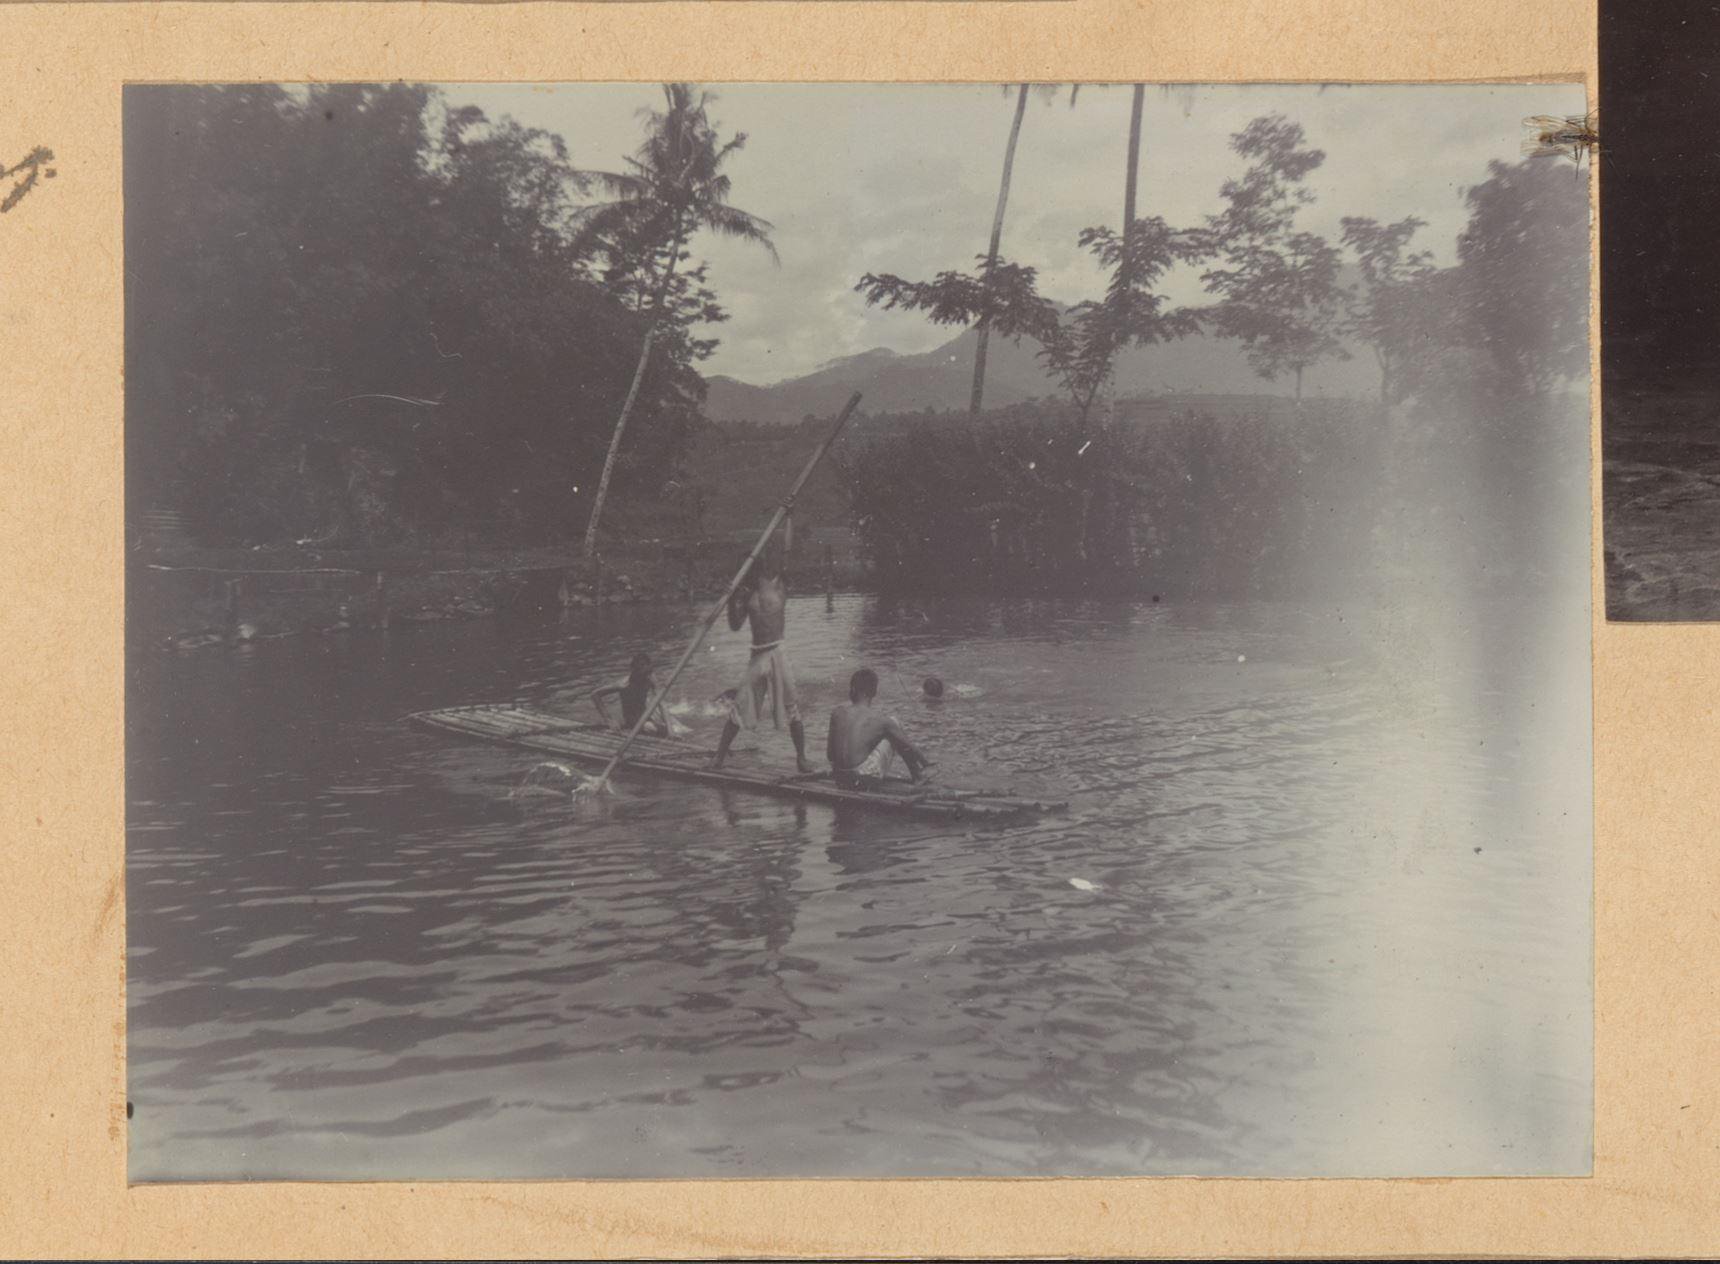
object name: photograph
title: Jongens op een vlot bij Kali Taman in Nederlands-Indië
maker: Anonymous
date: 1917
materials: photographic support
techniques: gelatin silver print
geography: dutch east indies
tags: river, child, raft, dutch east indies, the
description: Onderdeel van Familiealbum met foto's van een familie in de voormalige kolonie Nederlands-Indië en van een suikerfabriek in Purworejo.